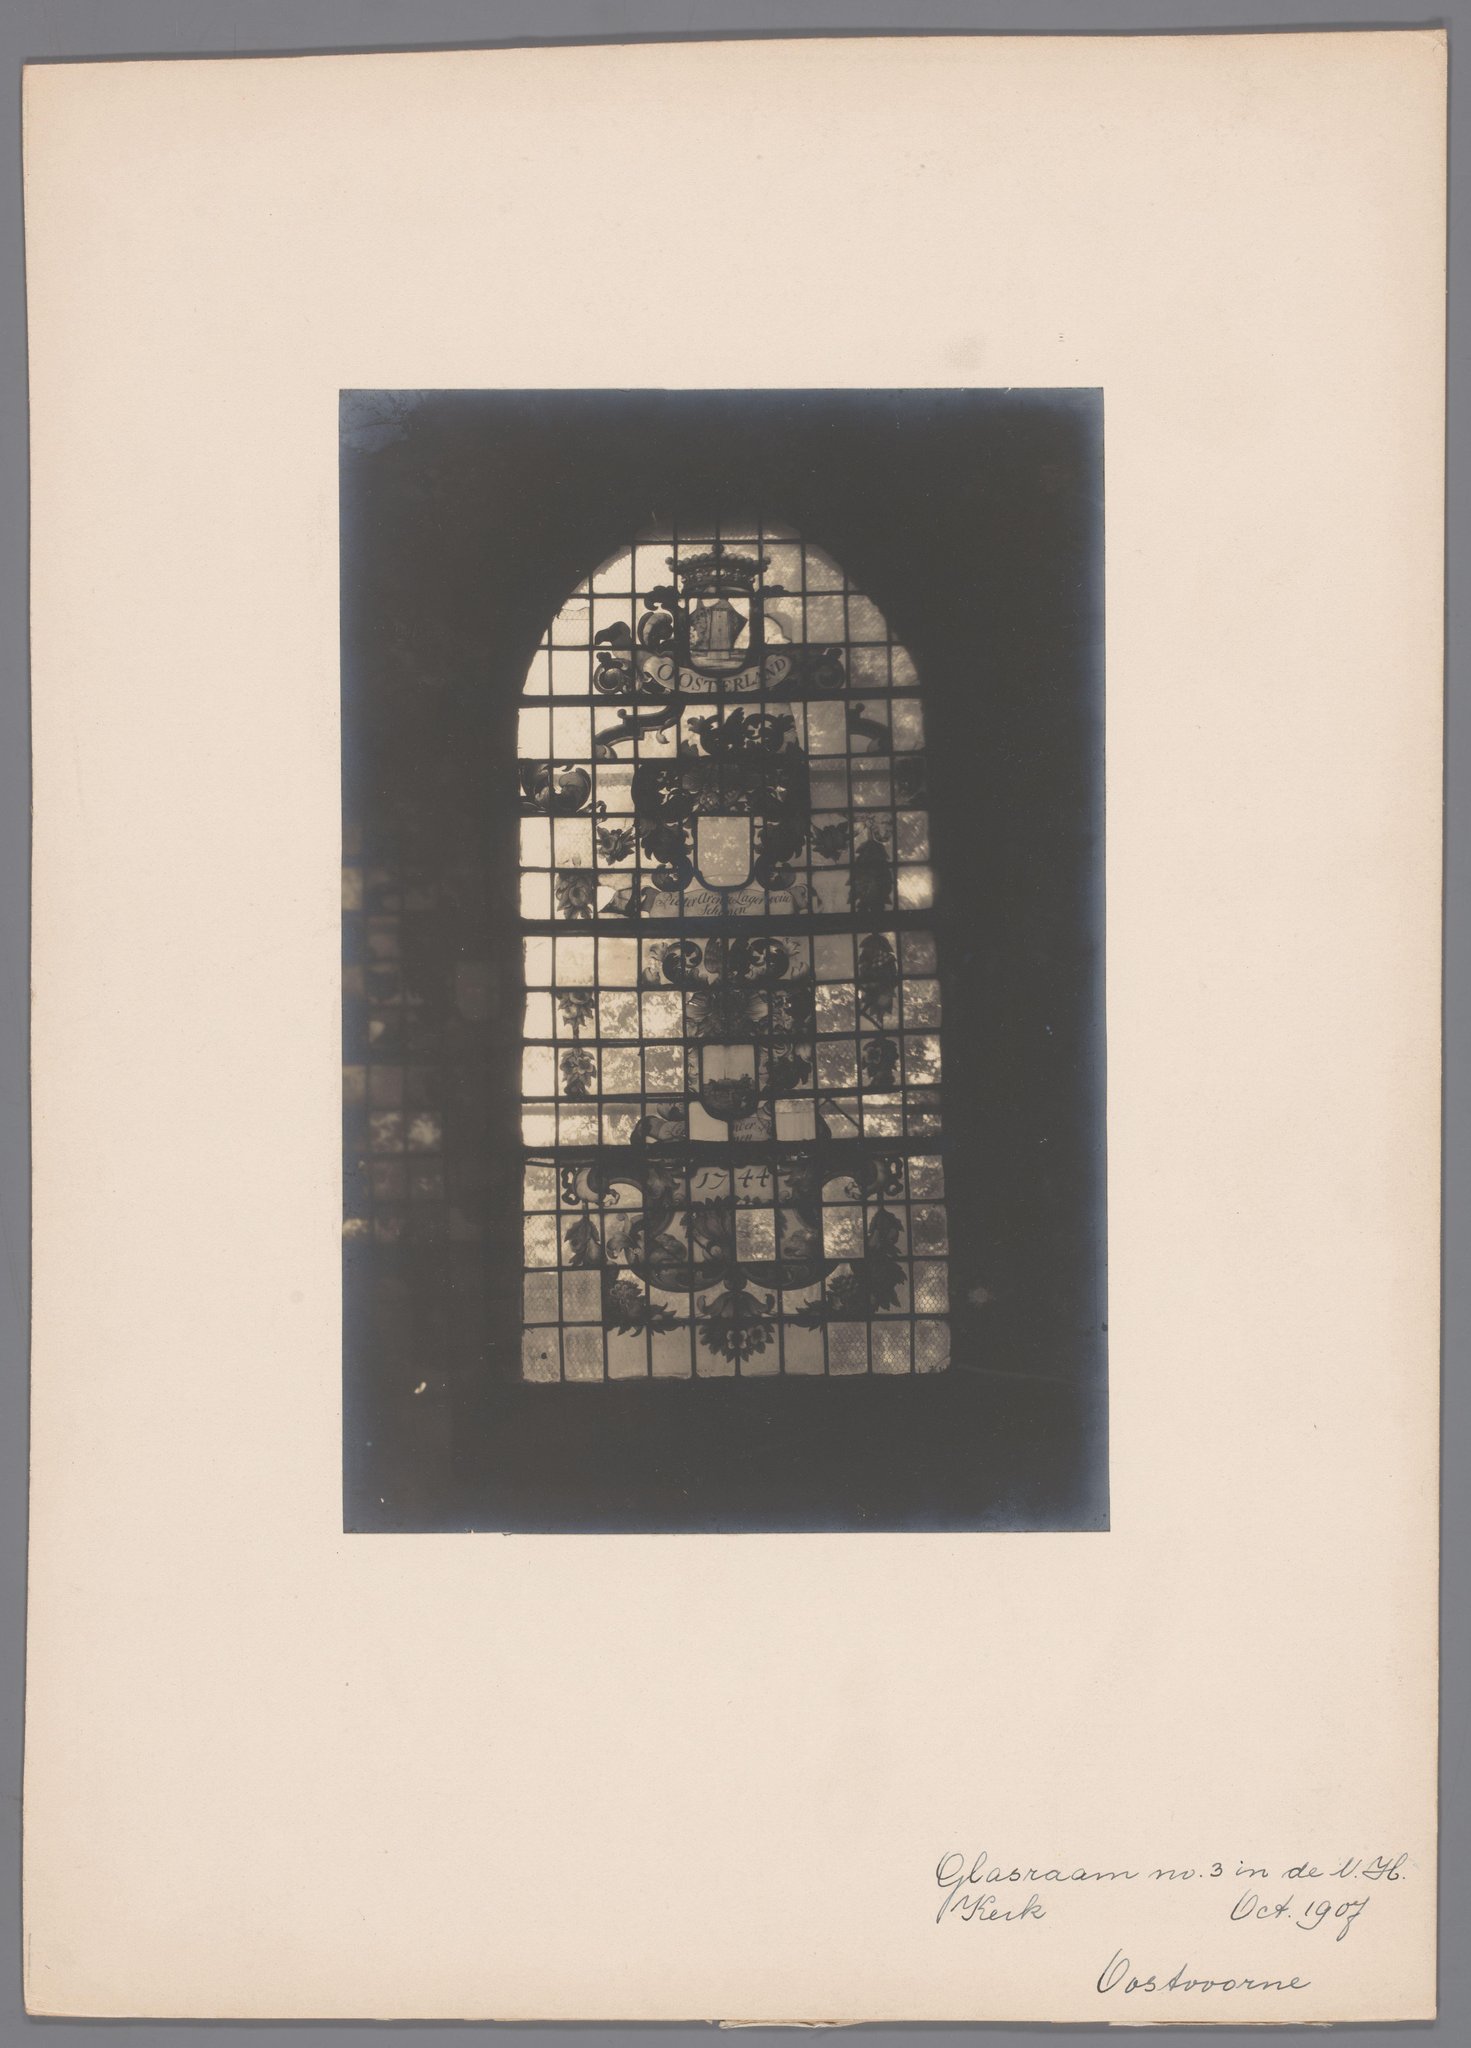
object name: photograph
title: Geschilderd raam in de Dorpskerk te Oostvoorne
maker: anoniem (monumentenzorg)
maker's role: fotograaf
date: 1907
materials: cardboard, photographic support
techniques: gelatin silver print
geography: oostvoorne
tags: church-window, e.g. rose-window, oostvoorne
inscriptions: annotation: ‘Glasraam no. 3 in de N.H. Kerk/ Oct. 1907/ Oostvoorne’, annotation: ‘Oostvoorne (Z.H.)/ glasraam N:3 in de Ned. Herv. Kerk/ october 1907’